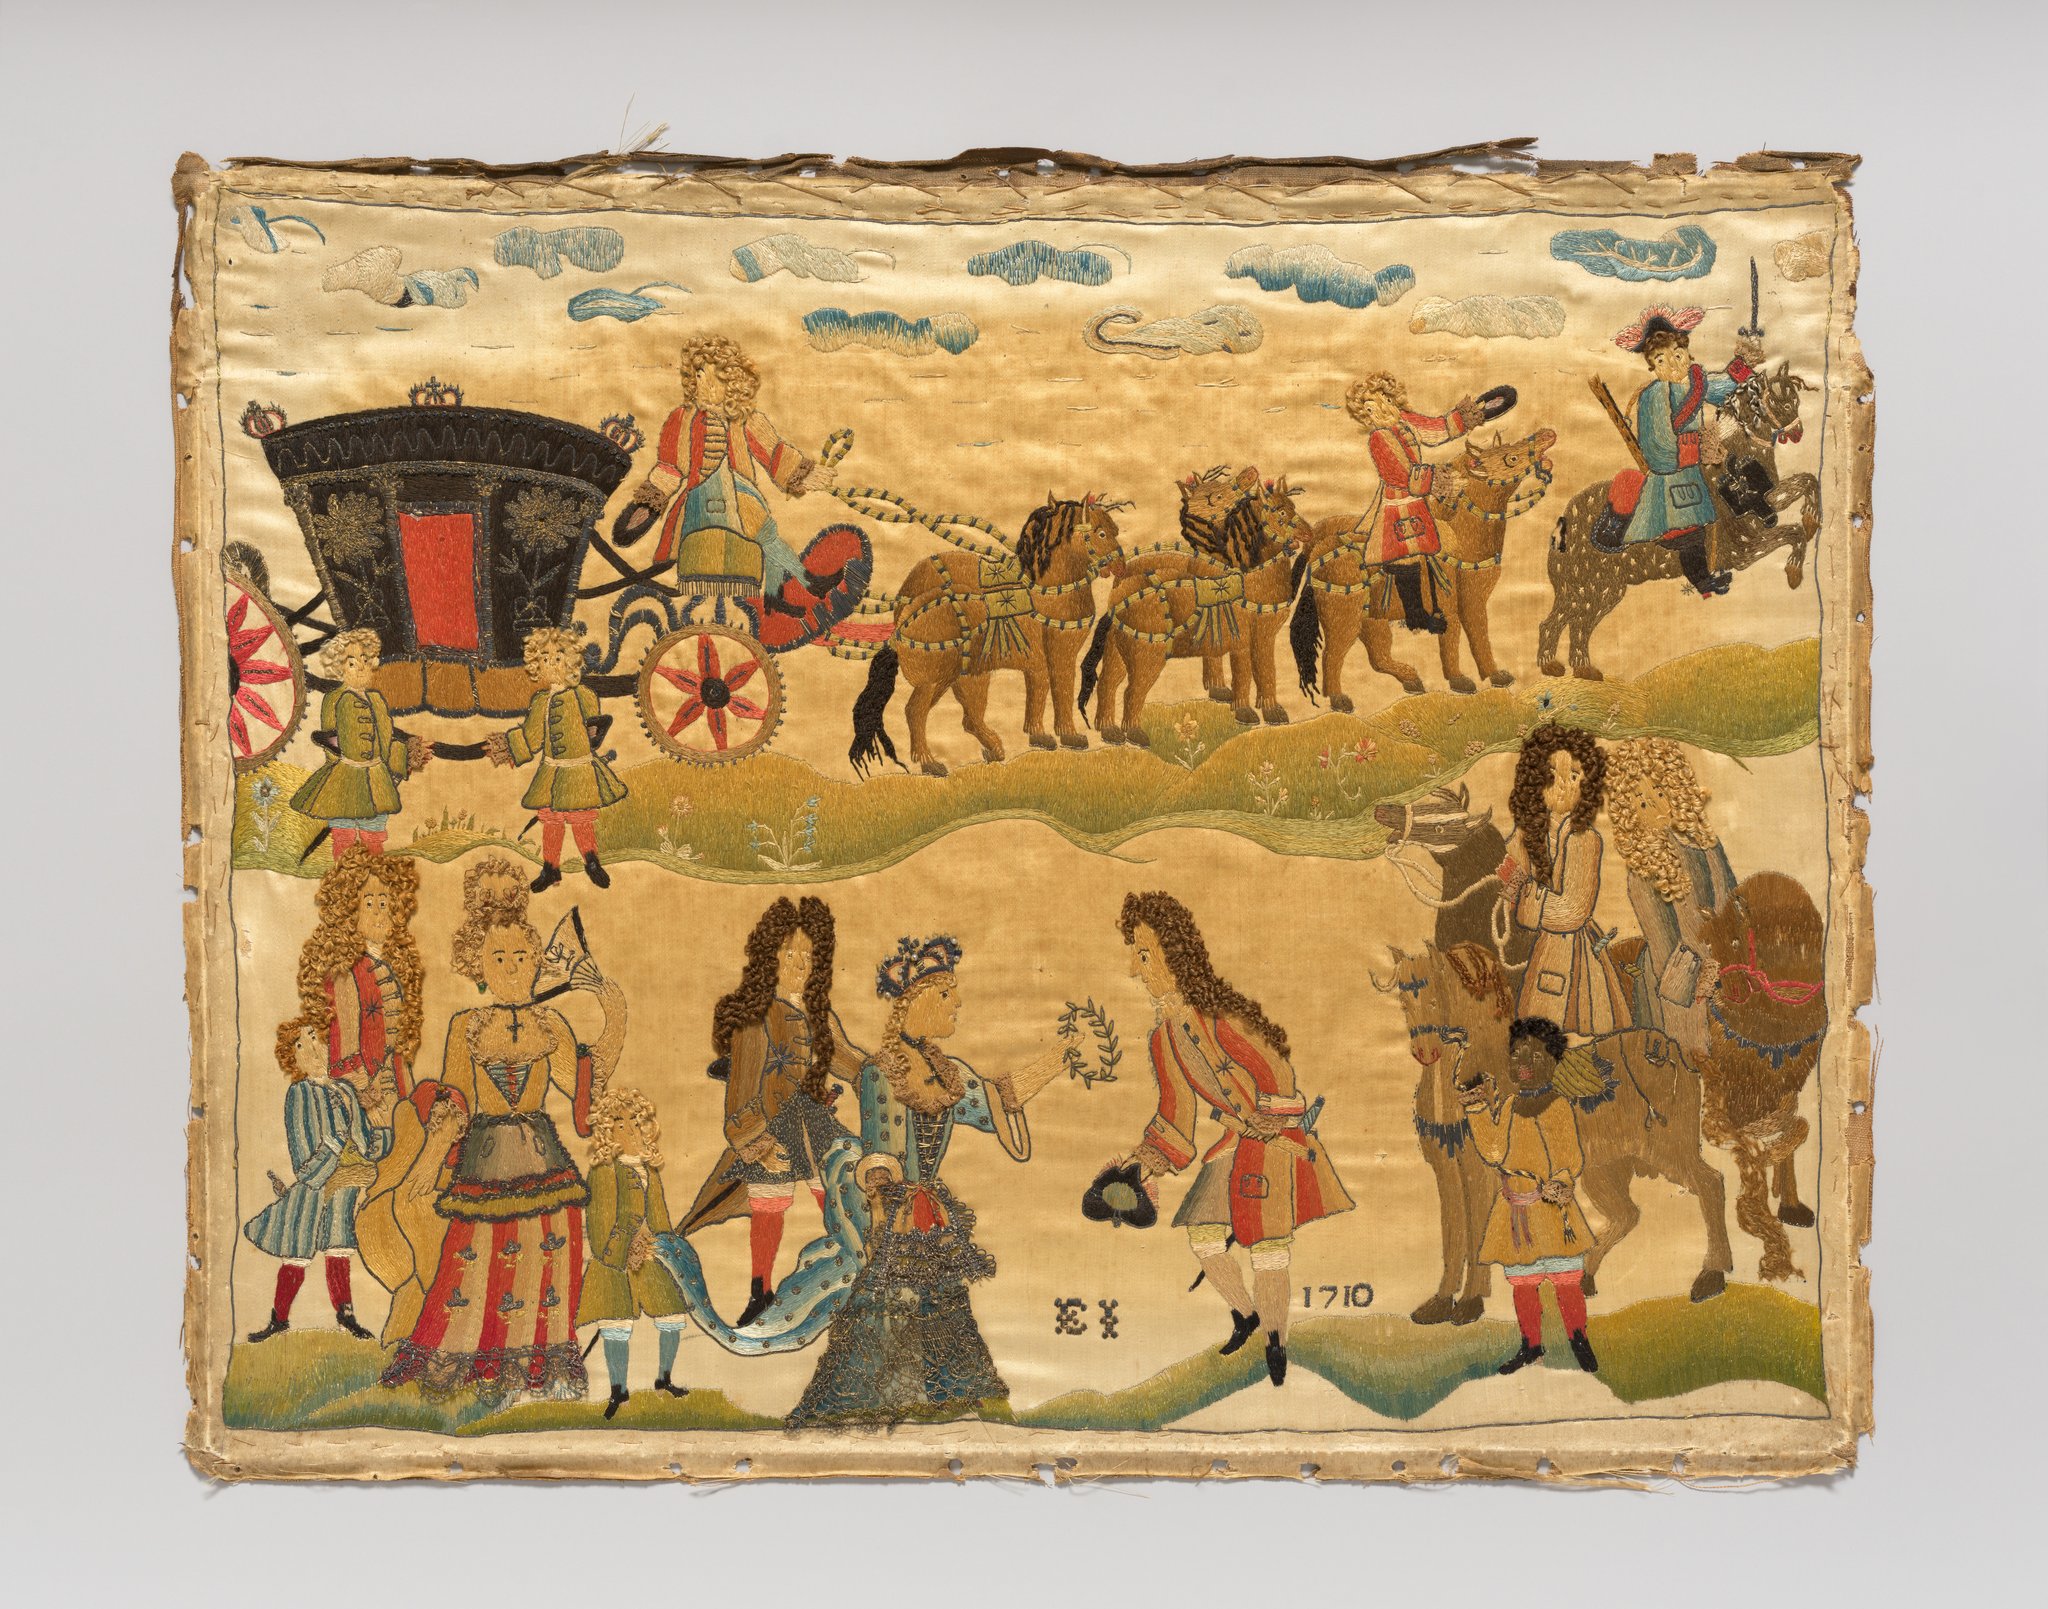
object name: embroidered picture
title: Embroidered picture of Queen Anne and the Duke of Marlborough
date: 1710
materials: metal thread, textile, silk, wool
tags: queens,men,horses,carriages